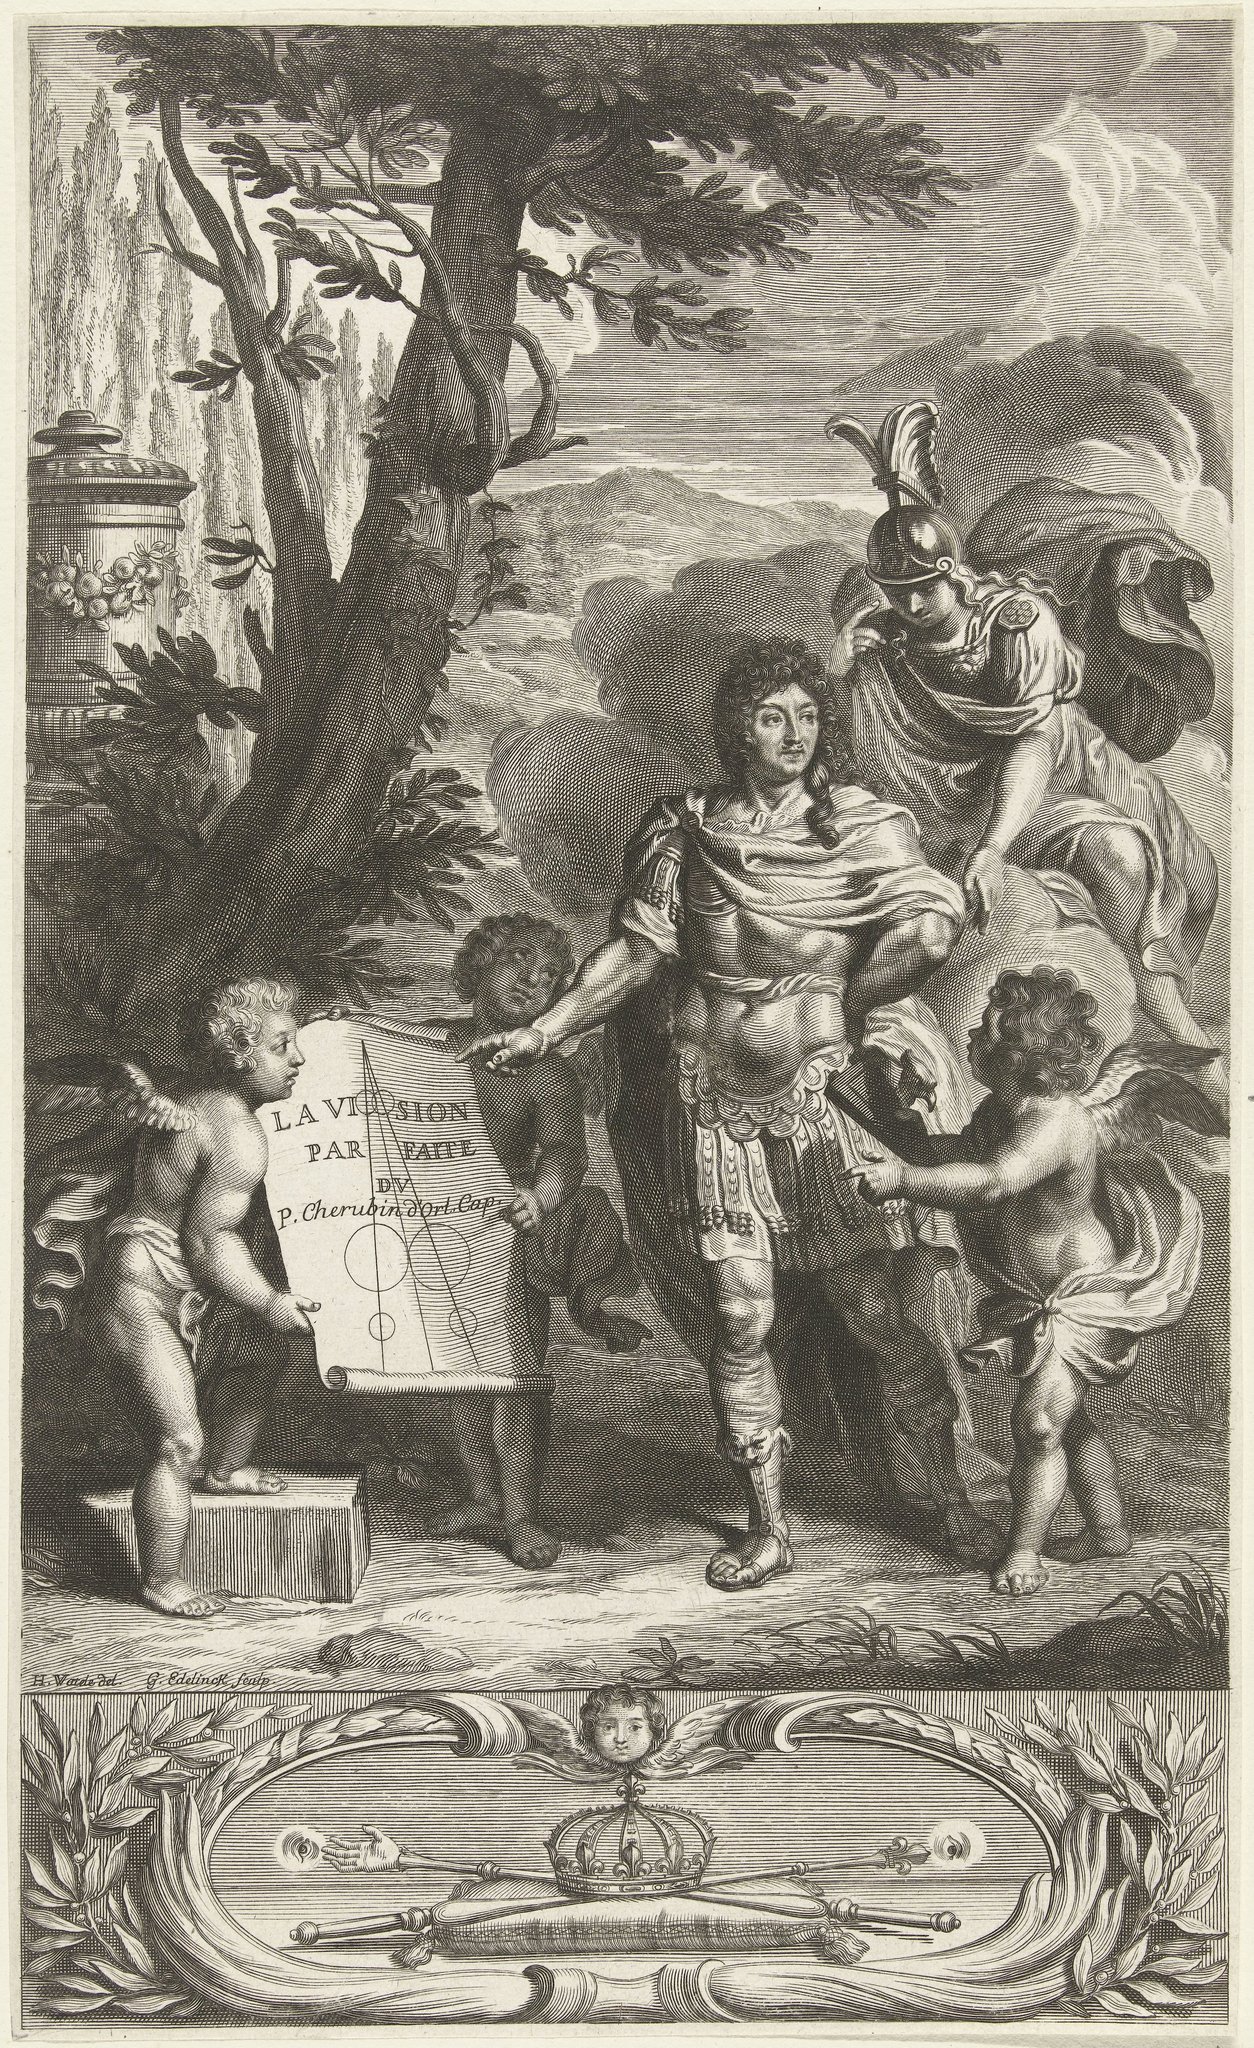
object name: print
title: Lodewijk de XIV in Romeins keizerskostuum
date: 1666-1707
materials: paper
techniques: engraving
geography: paris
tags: lodewijk xiv (koning van frankrijk)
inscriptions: collector's mark: Lugt 240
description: Lodewijk de XIV gekleed in Romeins keizerskostuum, wijst naar een document met geometrische vormen, vastgehouden door twee putti. Naast de koning staat een derde putto en achter hem Minerva. Onderaan een cartouche met koninklijke attributen.